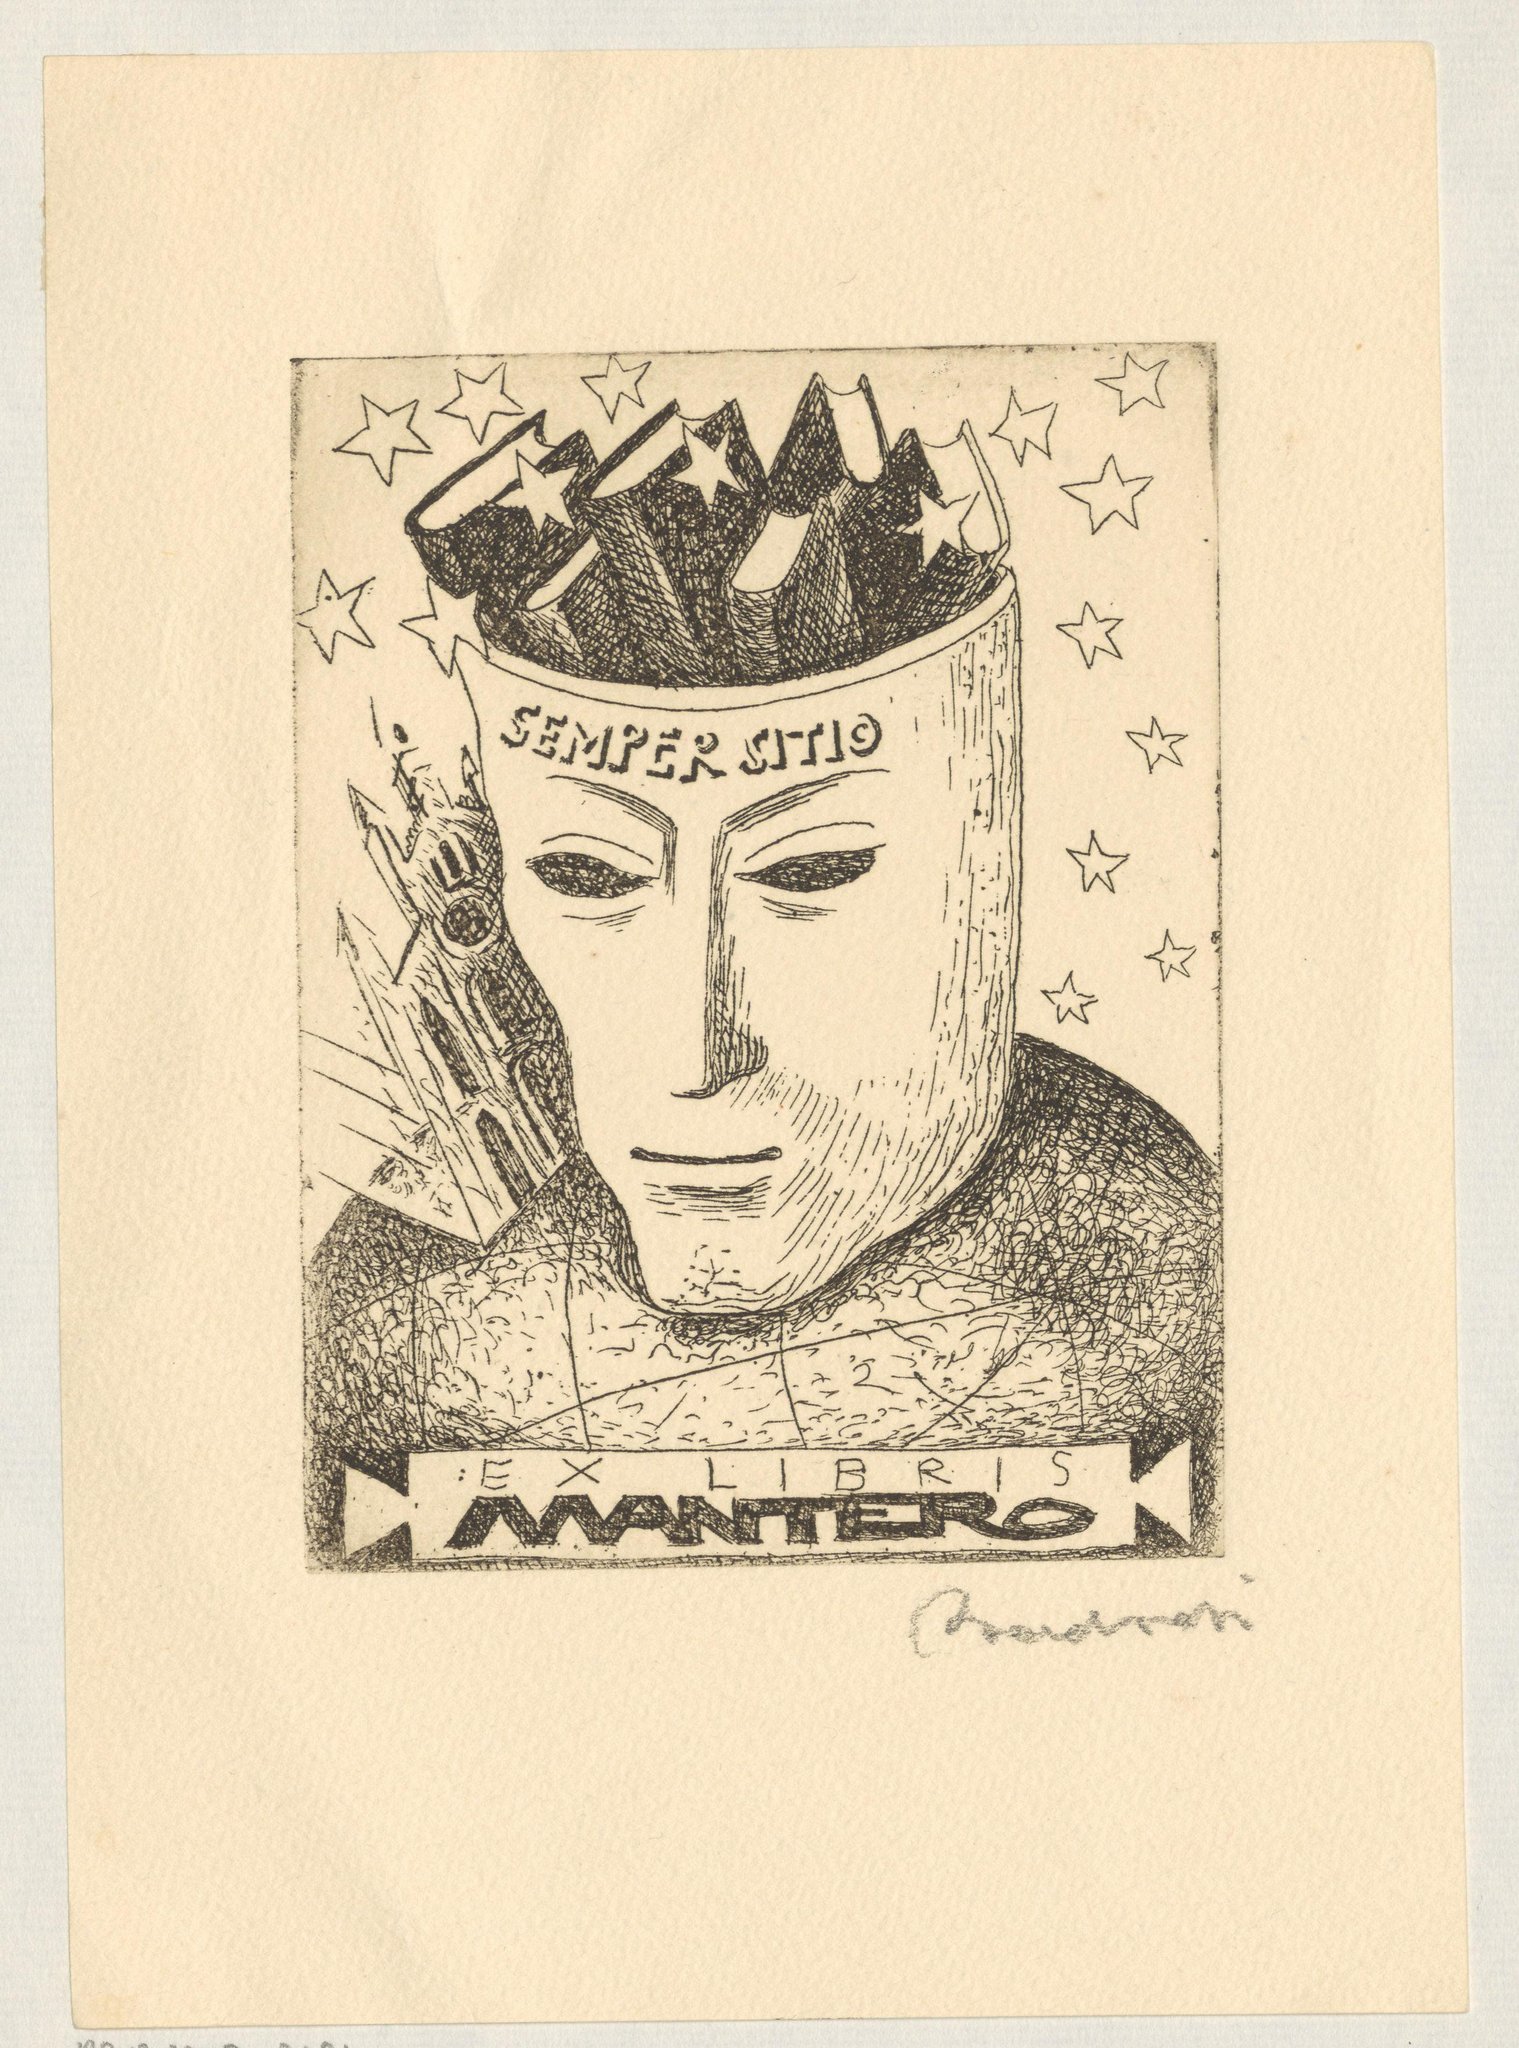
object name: bookplate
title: Ex libris van Mantero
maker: arnaldo badodi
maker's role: painter, print maker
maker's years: 1913-1943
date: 1938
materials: paper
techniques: etching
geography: milan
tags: engineer, gianni mantero, head (internal), head (human), book, parts of church exterior and annexes: façade, stars, globe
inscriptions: workshop stamp: ‘A. Badodi / Milano 1938 / Aquaforte - eaux forte / Radierung’, signature: ‘Badodi’